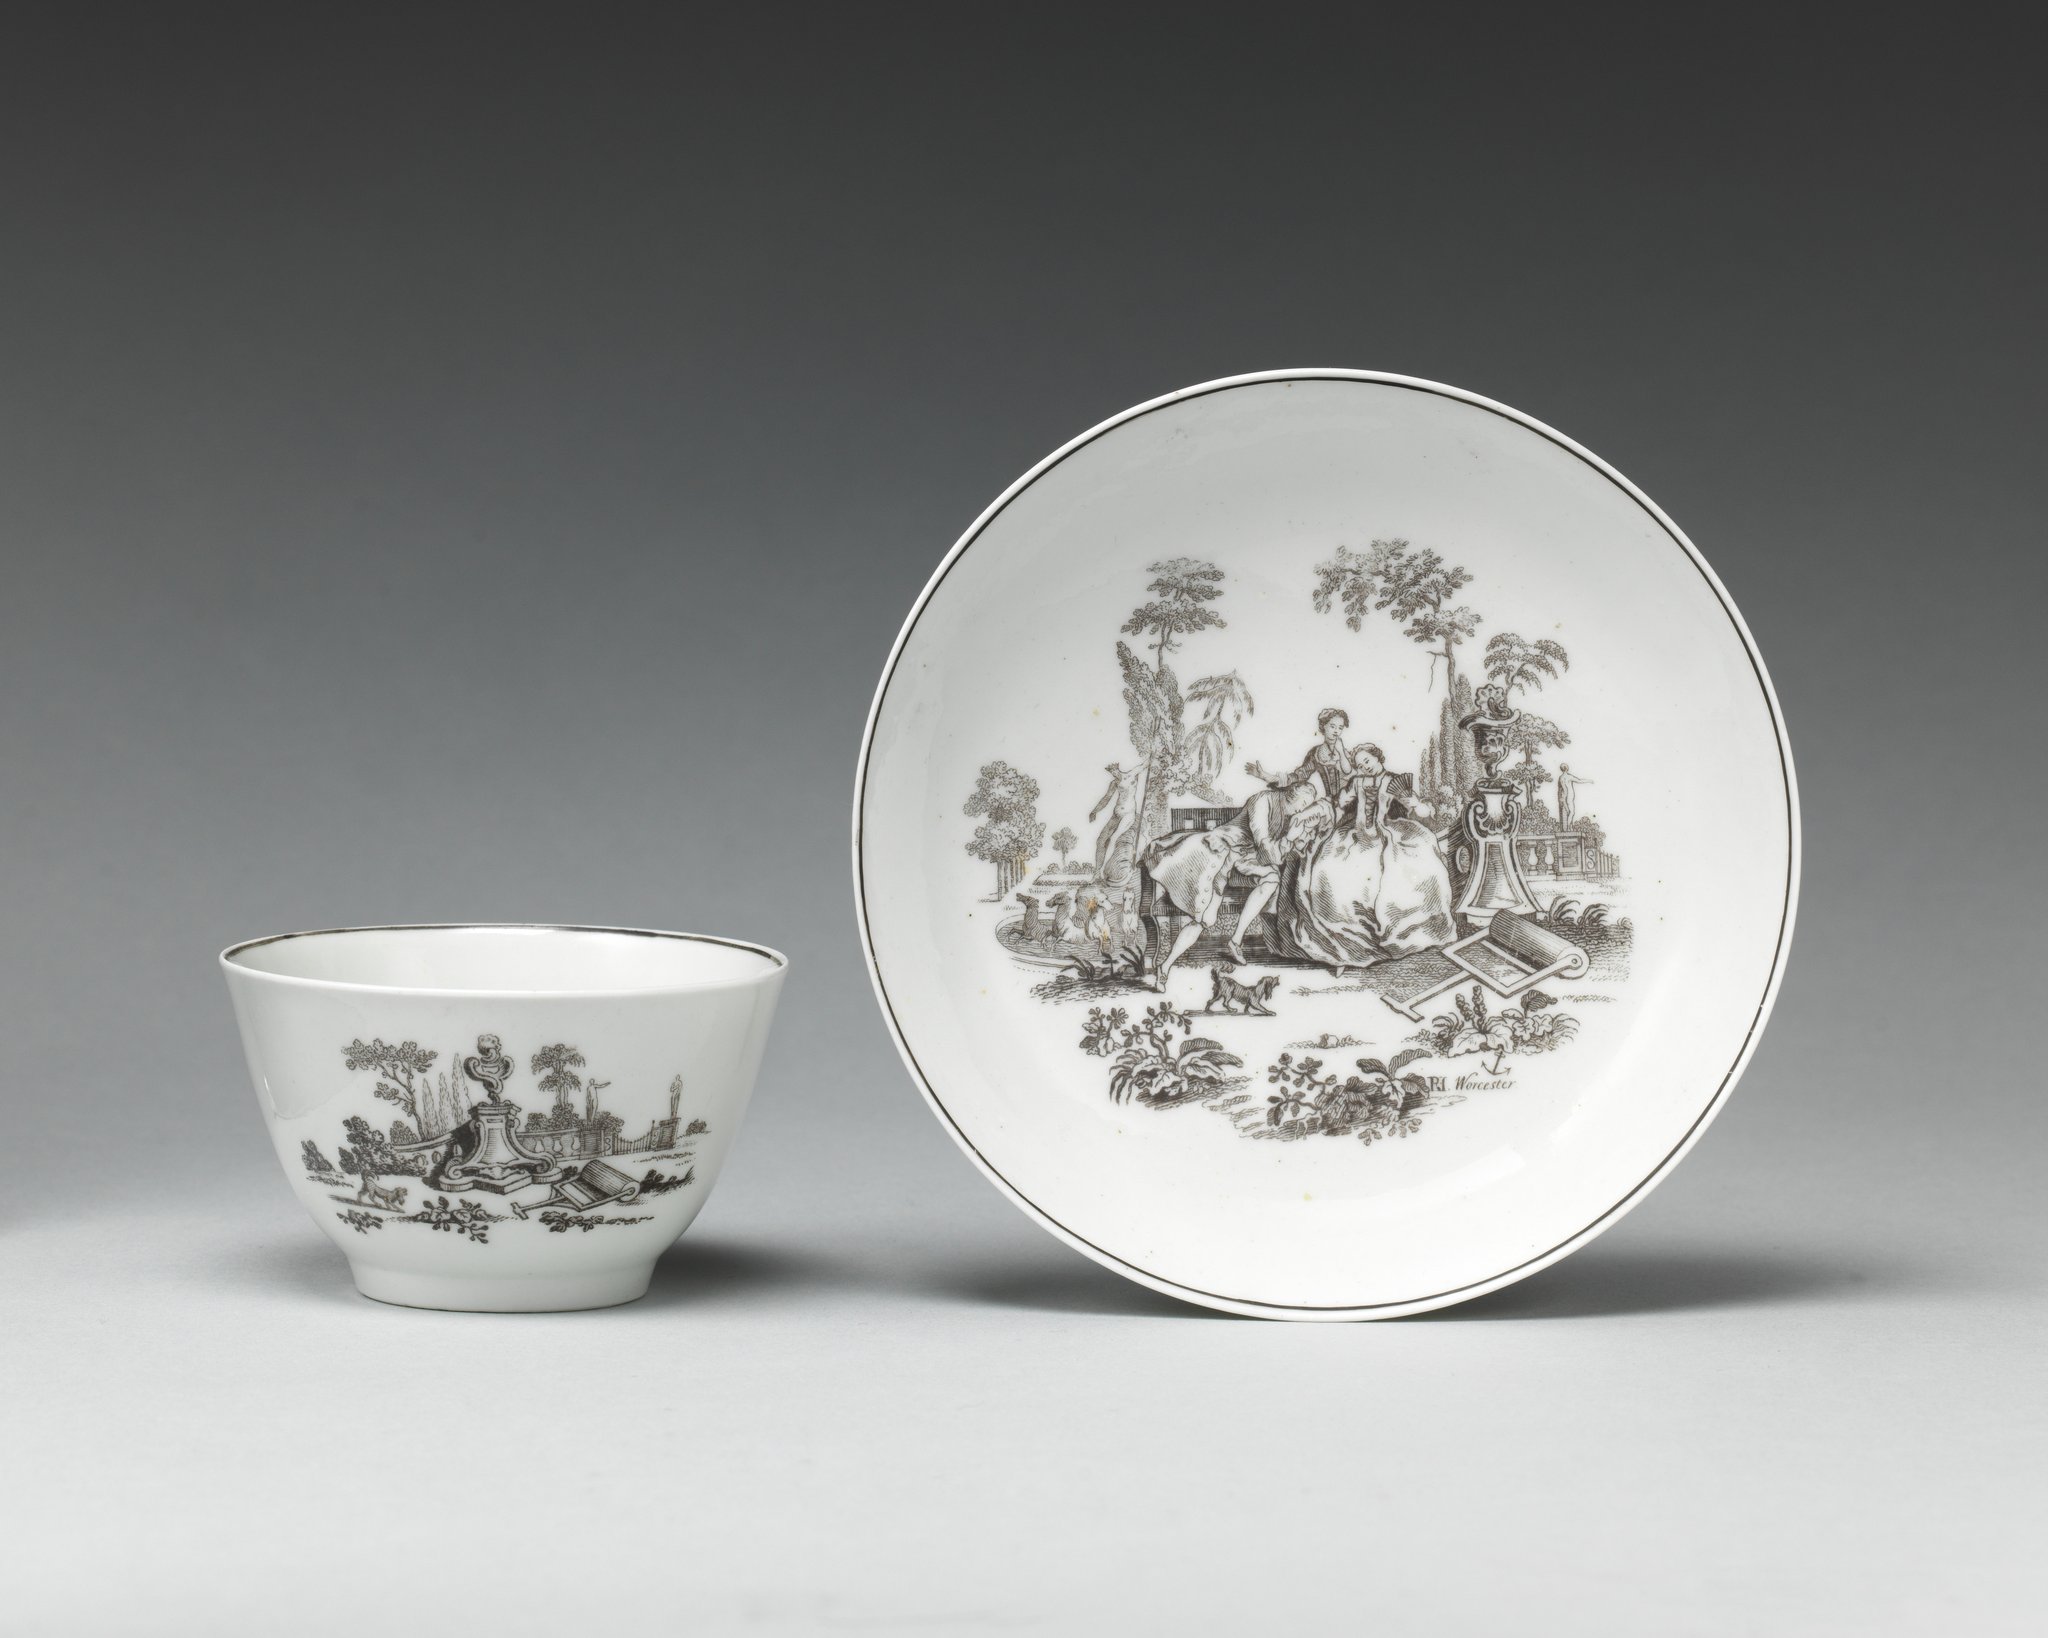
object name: cup and saucer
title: Cup and saucer (part of a set of four)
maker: worcester factory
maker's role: factory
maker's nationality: british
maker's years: 1751-2008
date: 1765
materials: soft paste porcelain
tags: men,women,trees